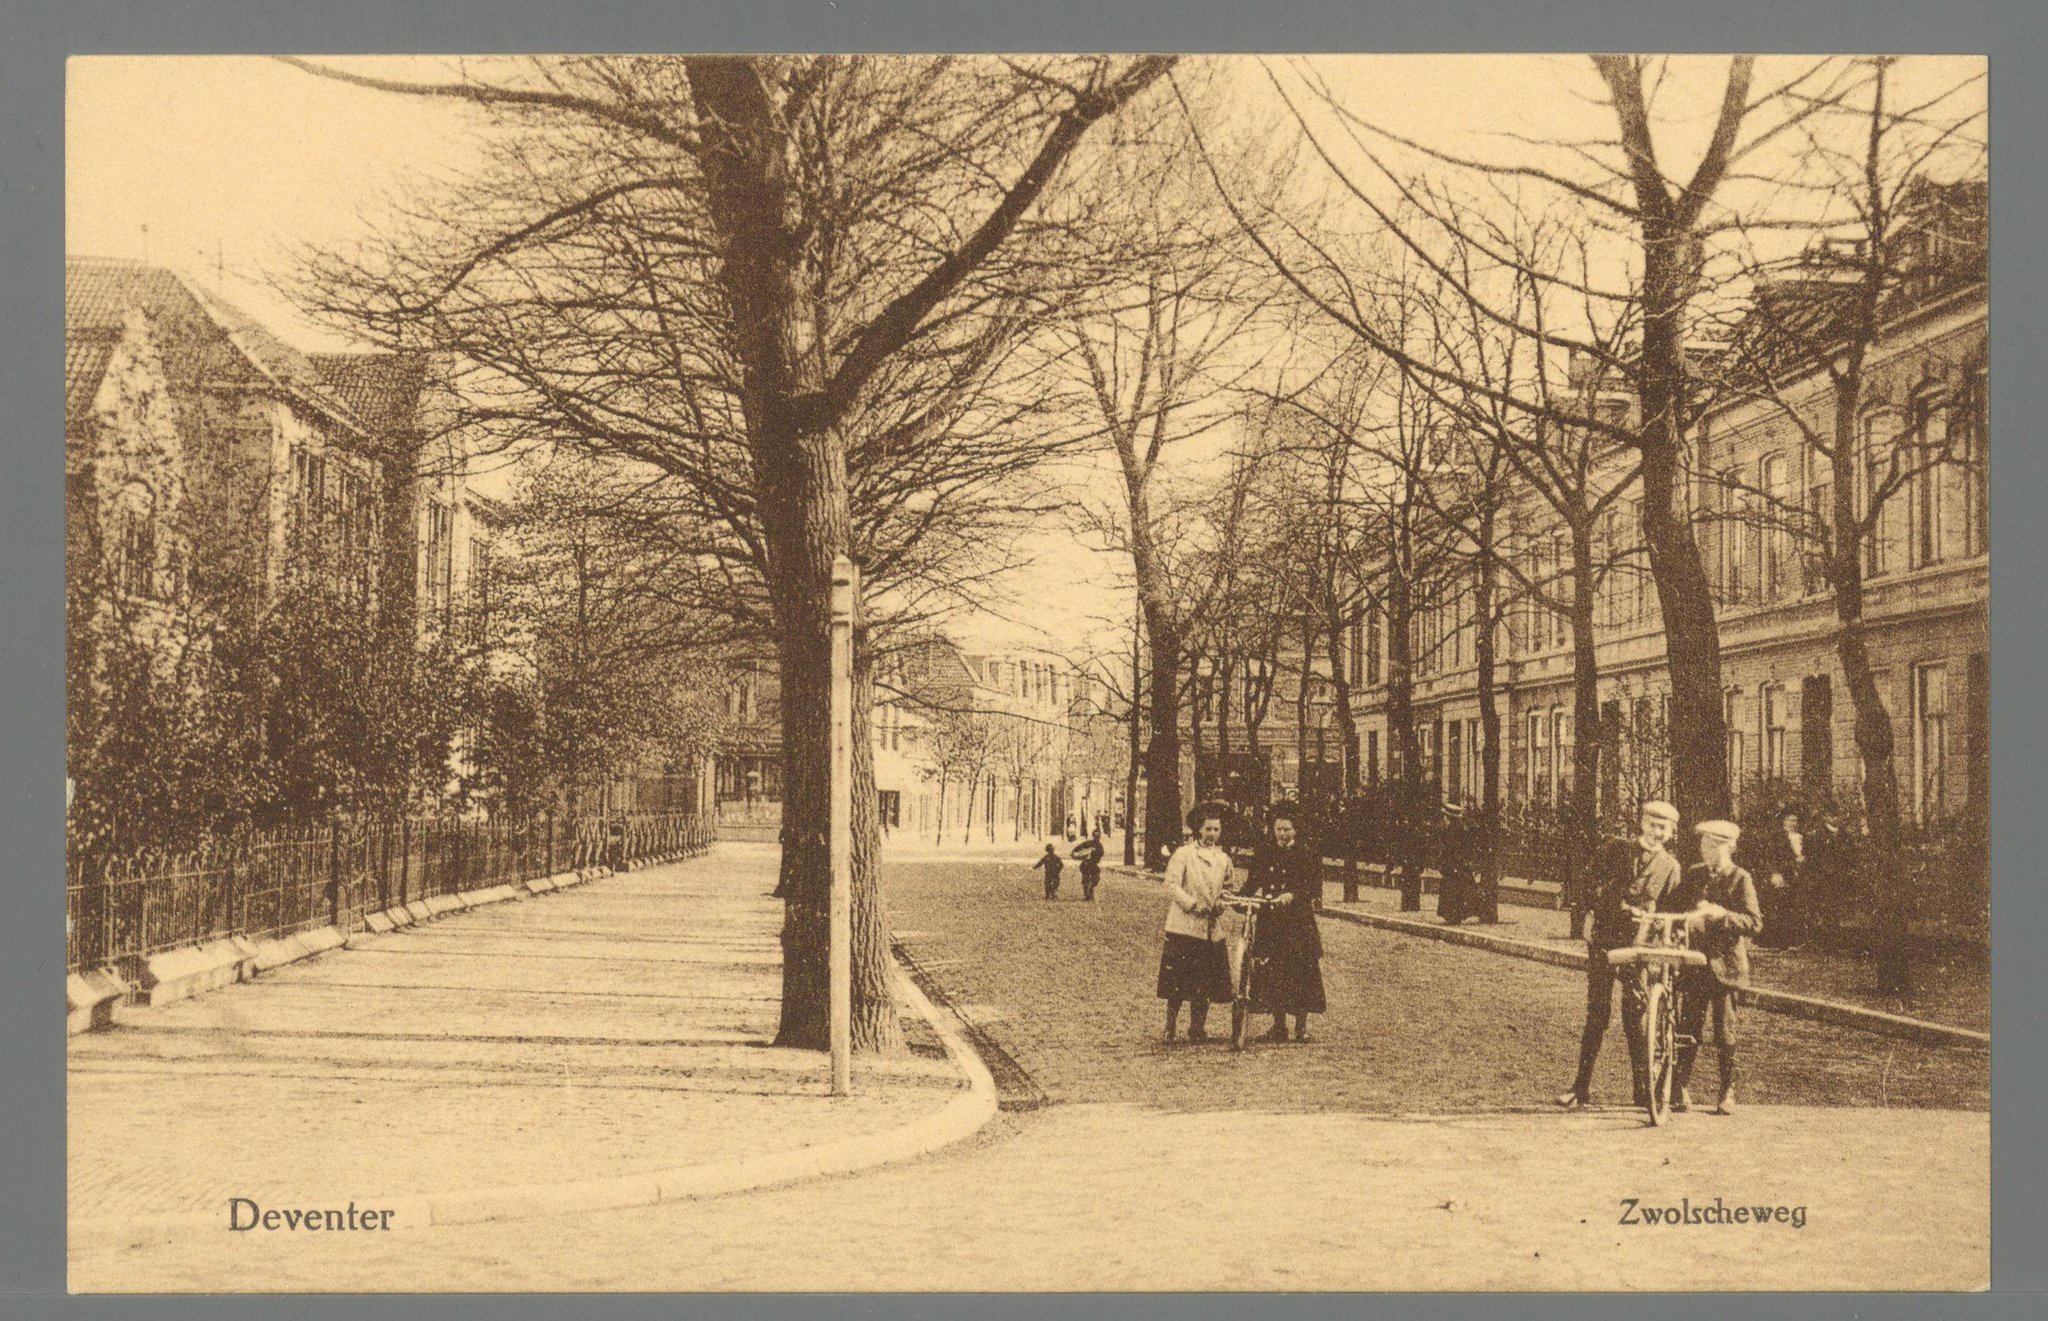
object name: ansichtkaart, prentbriefkaart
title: Deventer. Zwolscheweg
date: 1905-1930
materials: cardboard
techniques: photograph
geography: deventer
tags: street, deventer